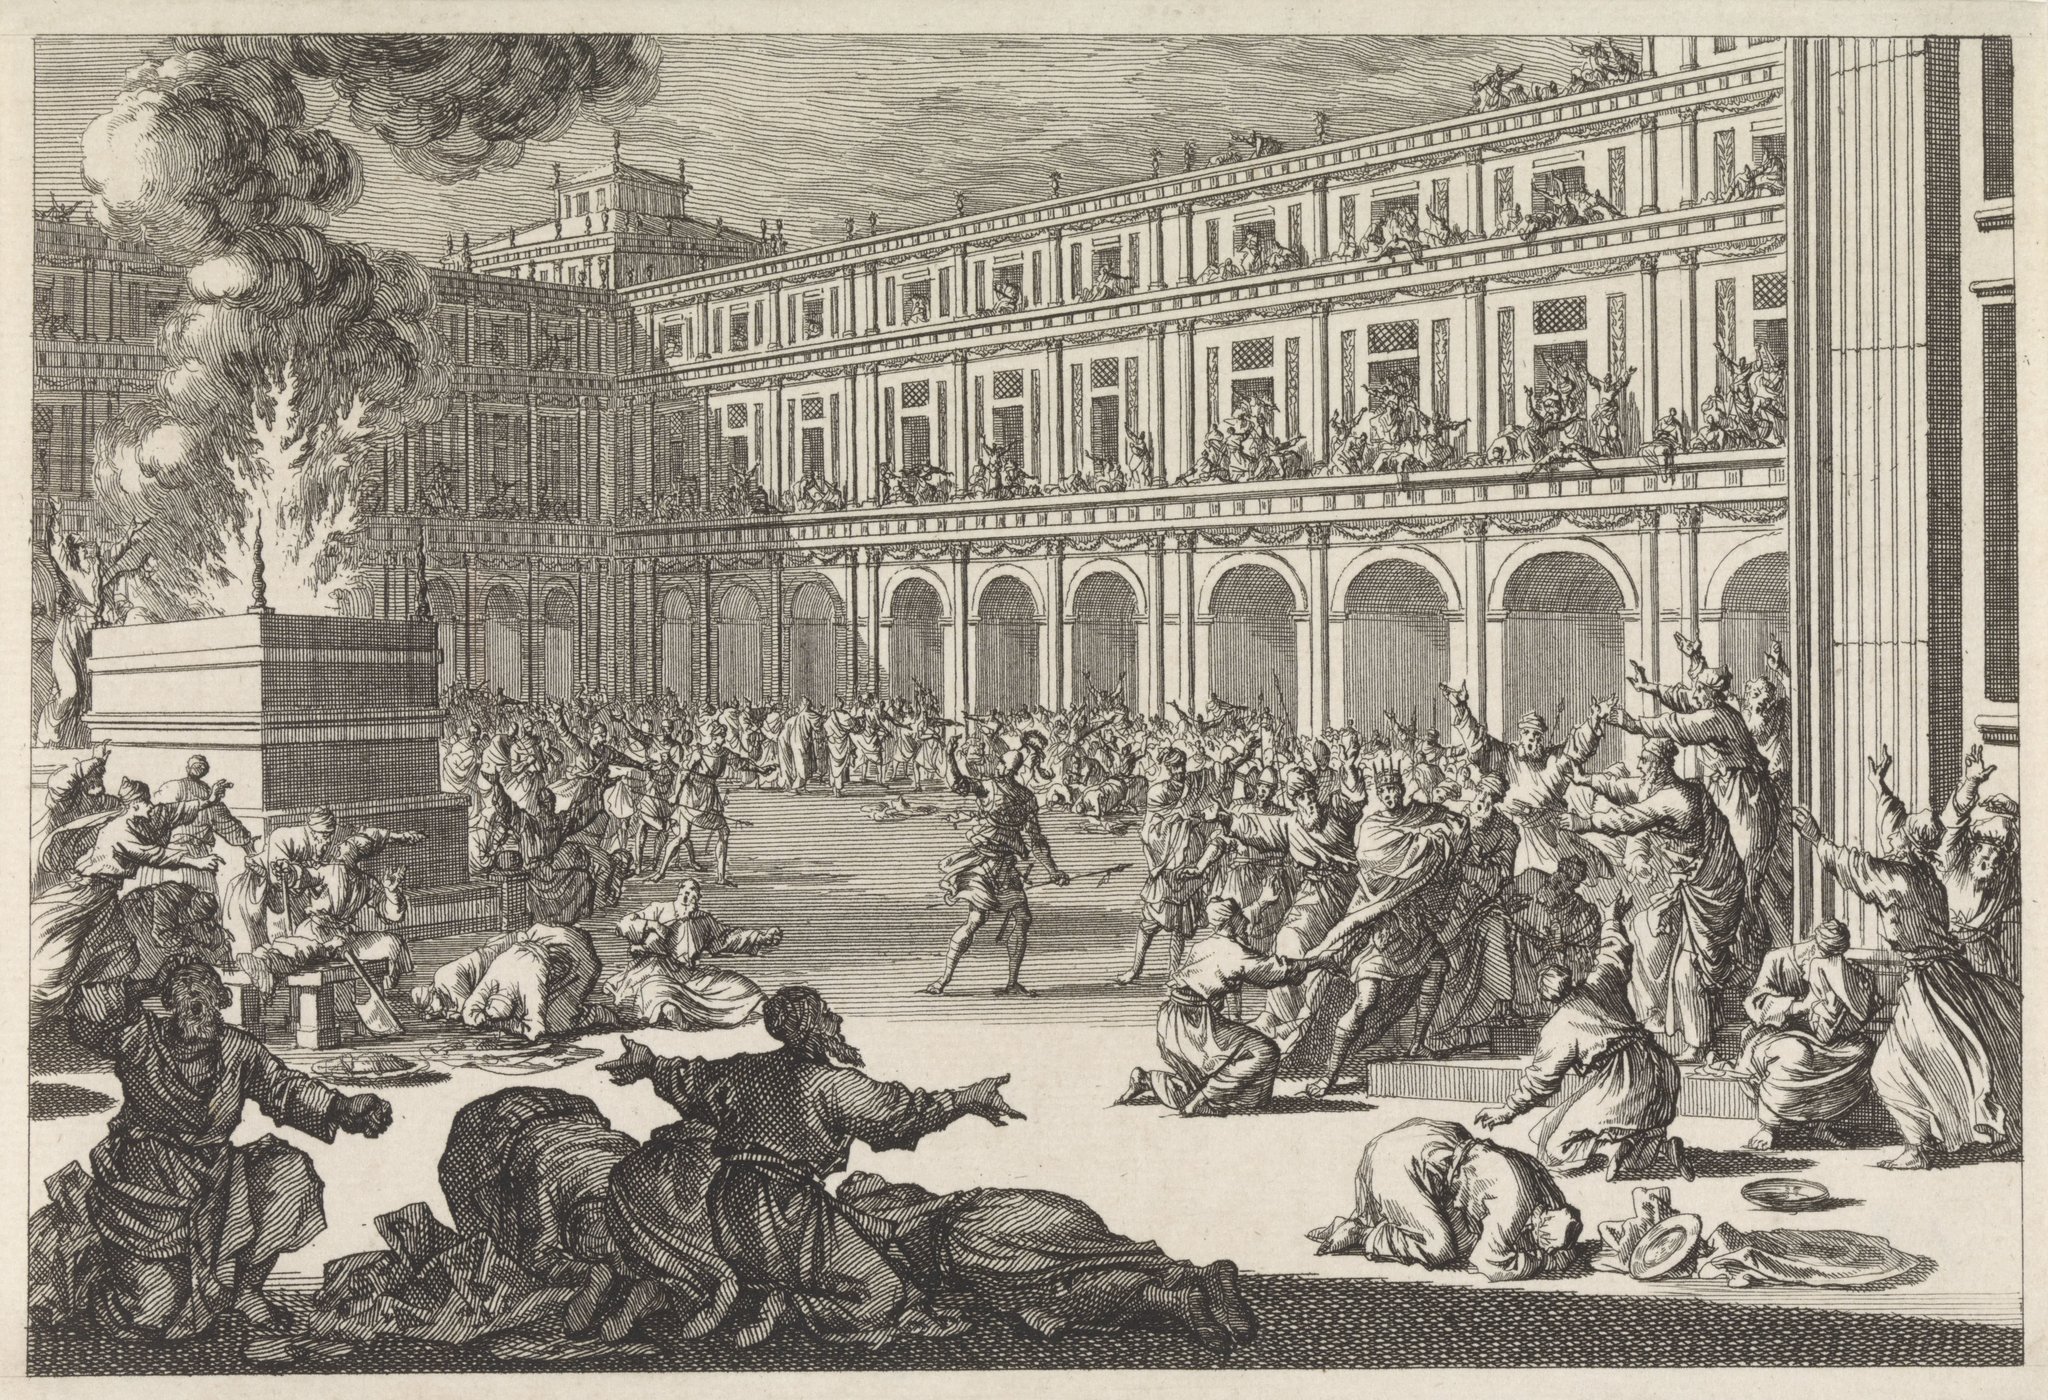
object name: print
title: Koning Ptolemaeus Philopator krijgt een beroerte als straf voor zijn nieuwsgierigheid naar het Heilige der Heiligen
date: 1700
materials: paper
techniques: etching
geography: amsterdam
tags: king ptolemy iv philopator struck by paralysis for coming too close to the sanctuary in the temple of jerusalem (3 maccabees 1-2)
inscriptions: collector's mark: Lugt 2228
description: Het centrale plein van Jeruzalem met de tempel van Salomo. Wanneer koning Ptolemaeus Philopator het Heilige der Heiligen in de tempel tracht binnen te treden, krijgt hij een beroerte, afkomstig van God als straf voor zijn nieuwsgierigheid. Het Joodse volk bidt in paniek tot God.